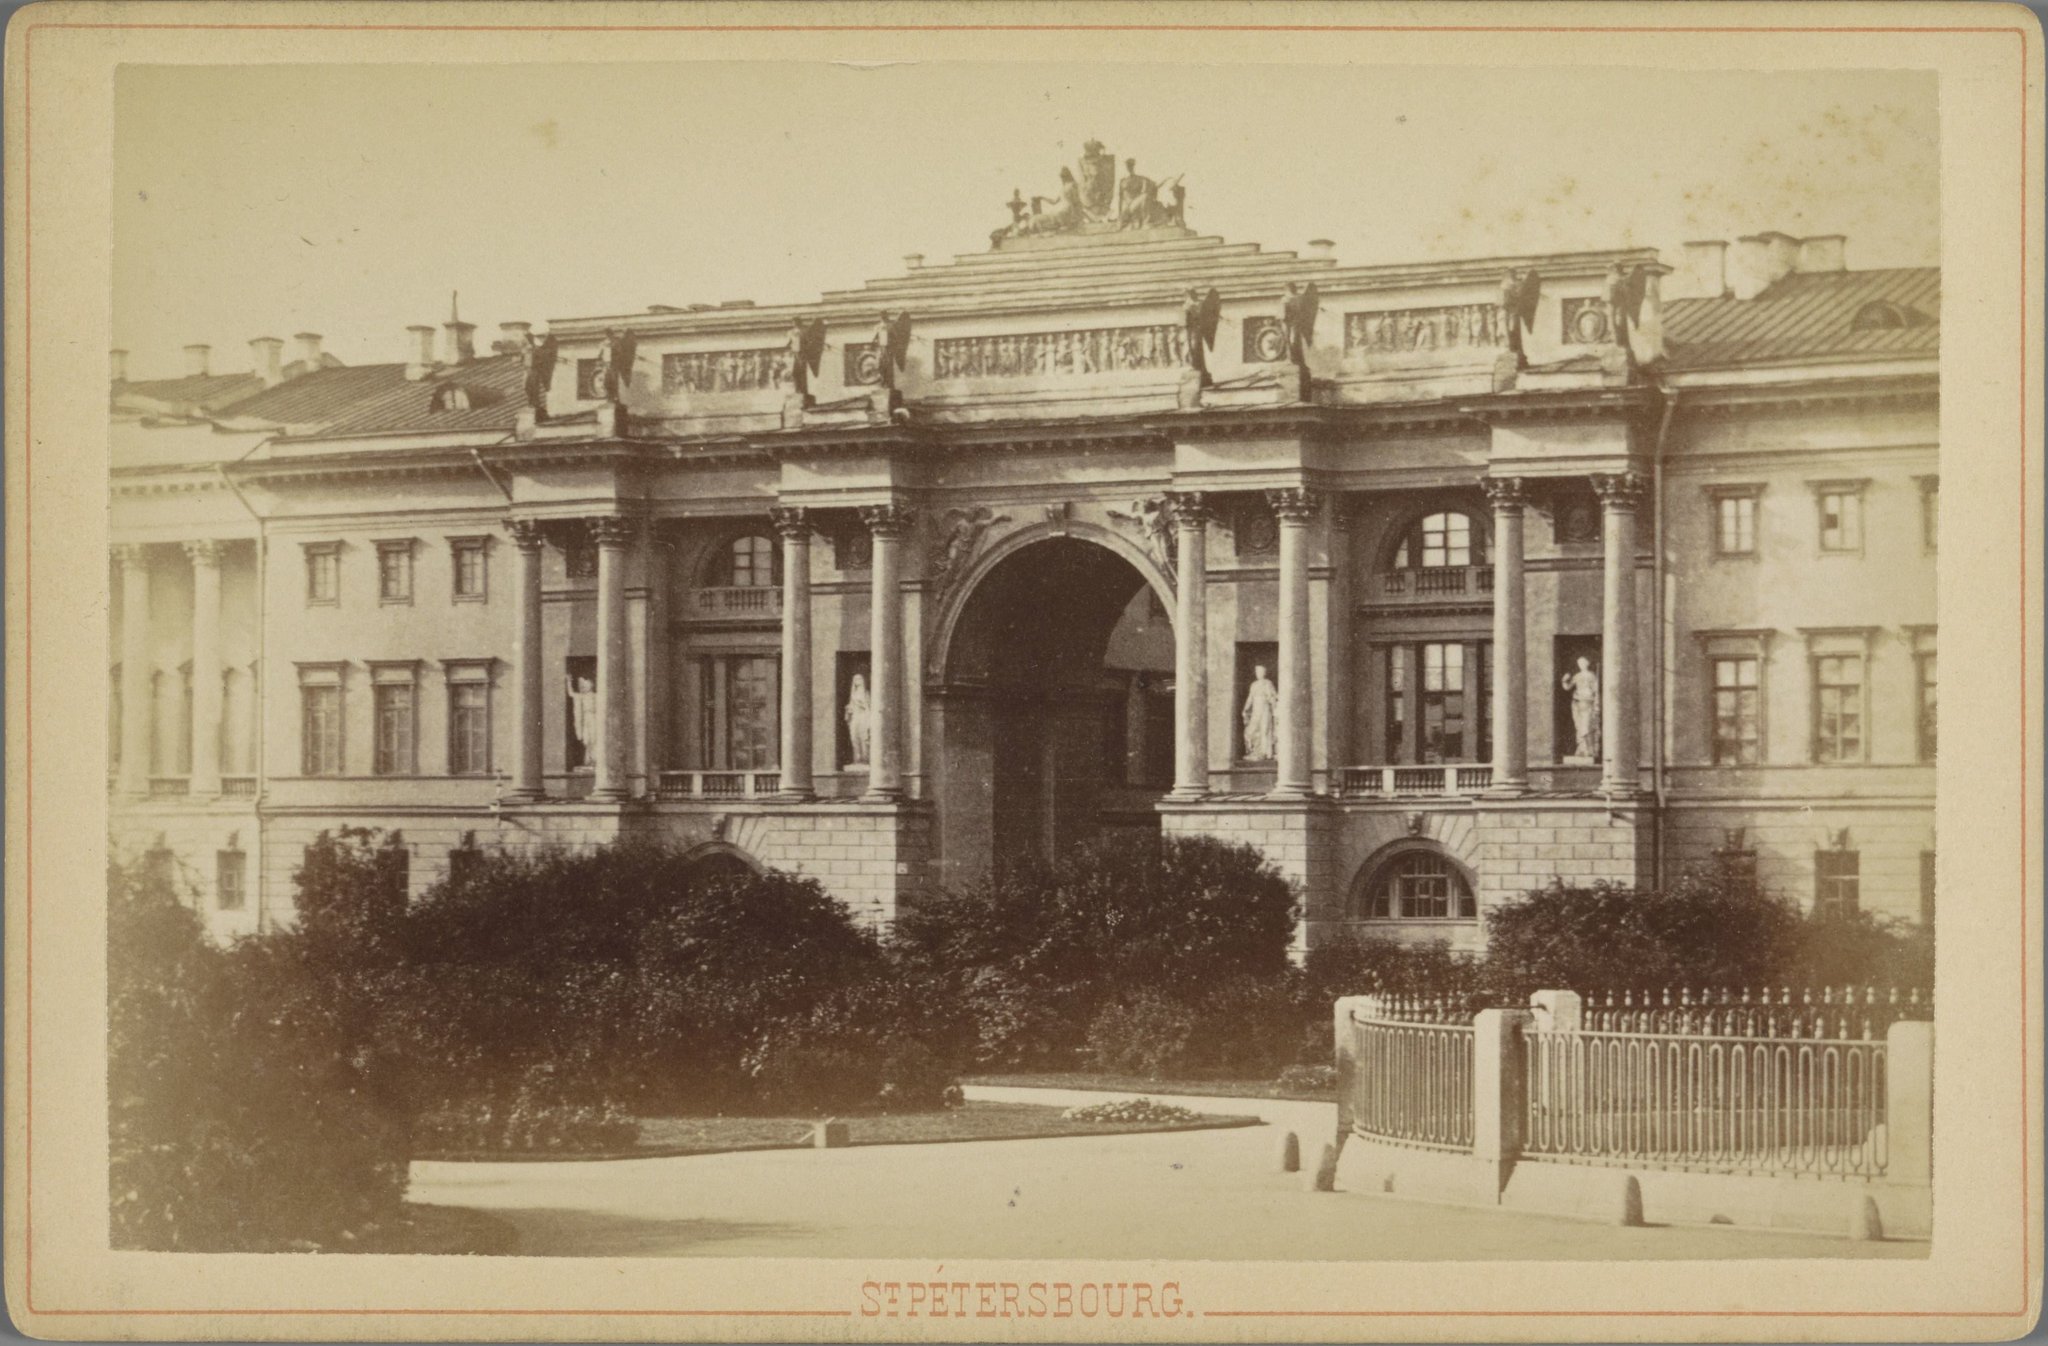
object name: photograph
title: St. Petersbourg.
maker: joseph daziaro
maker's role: publisher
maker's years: 1831-1892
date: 1880-1900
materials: cardboard, photographic support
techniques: albumen print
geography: sint-petersburg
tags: arch, archivolt ~ architecture, façade (of house or building), lower house, parliament, chamber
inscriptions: inscription: ‘Arc du Senat’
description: Onderdeel van Fotoalbum met opnames van Sint-Petersburg.